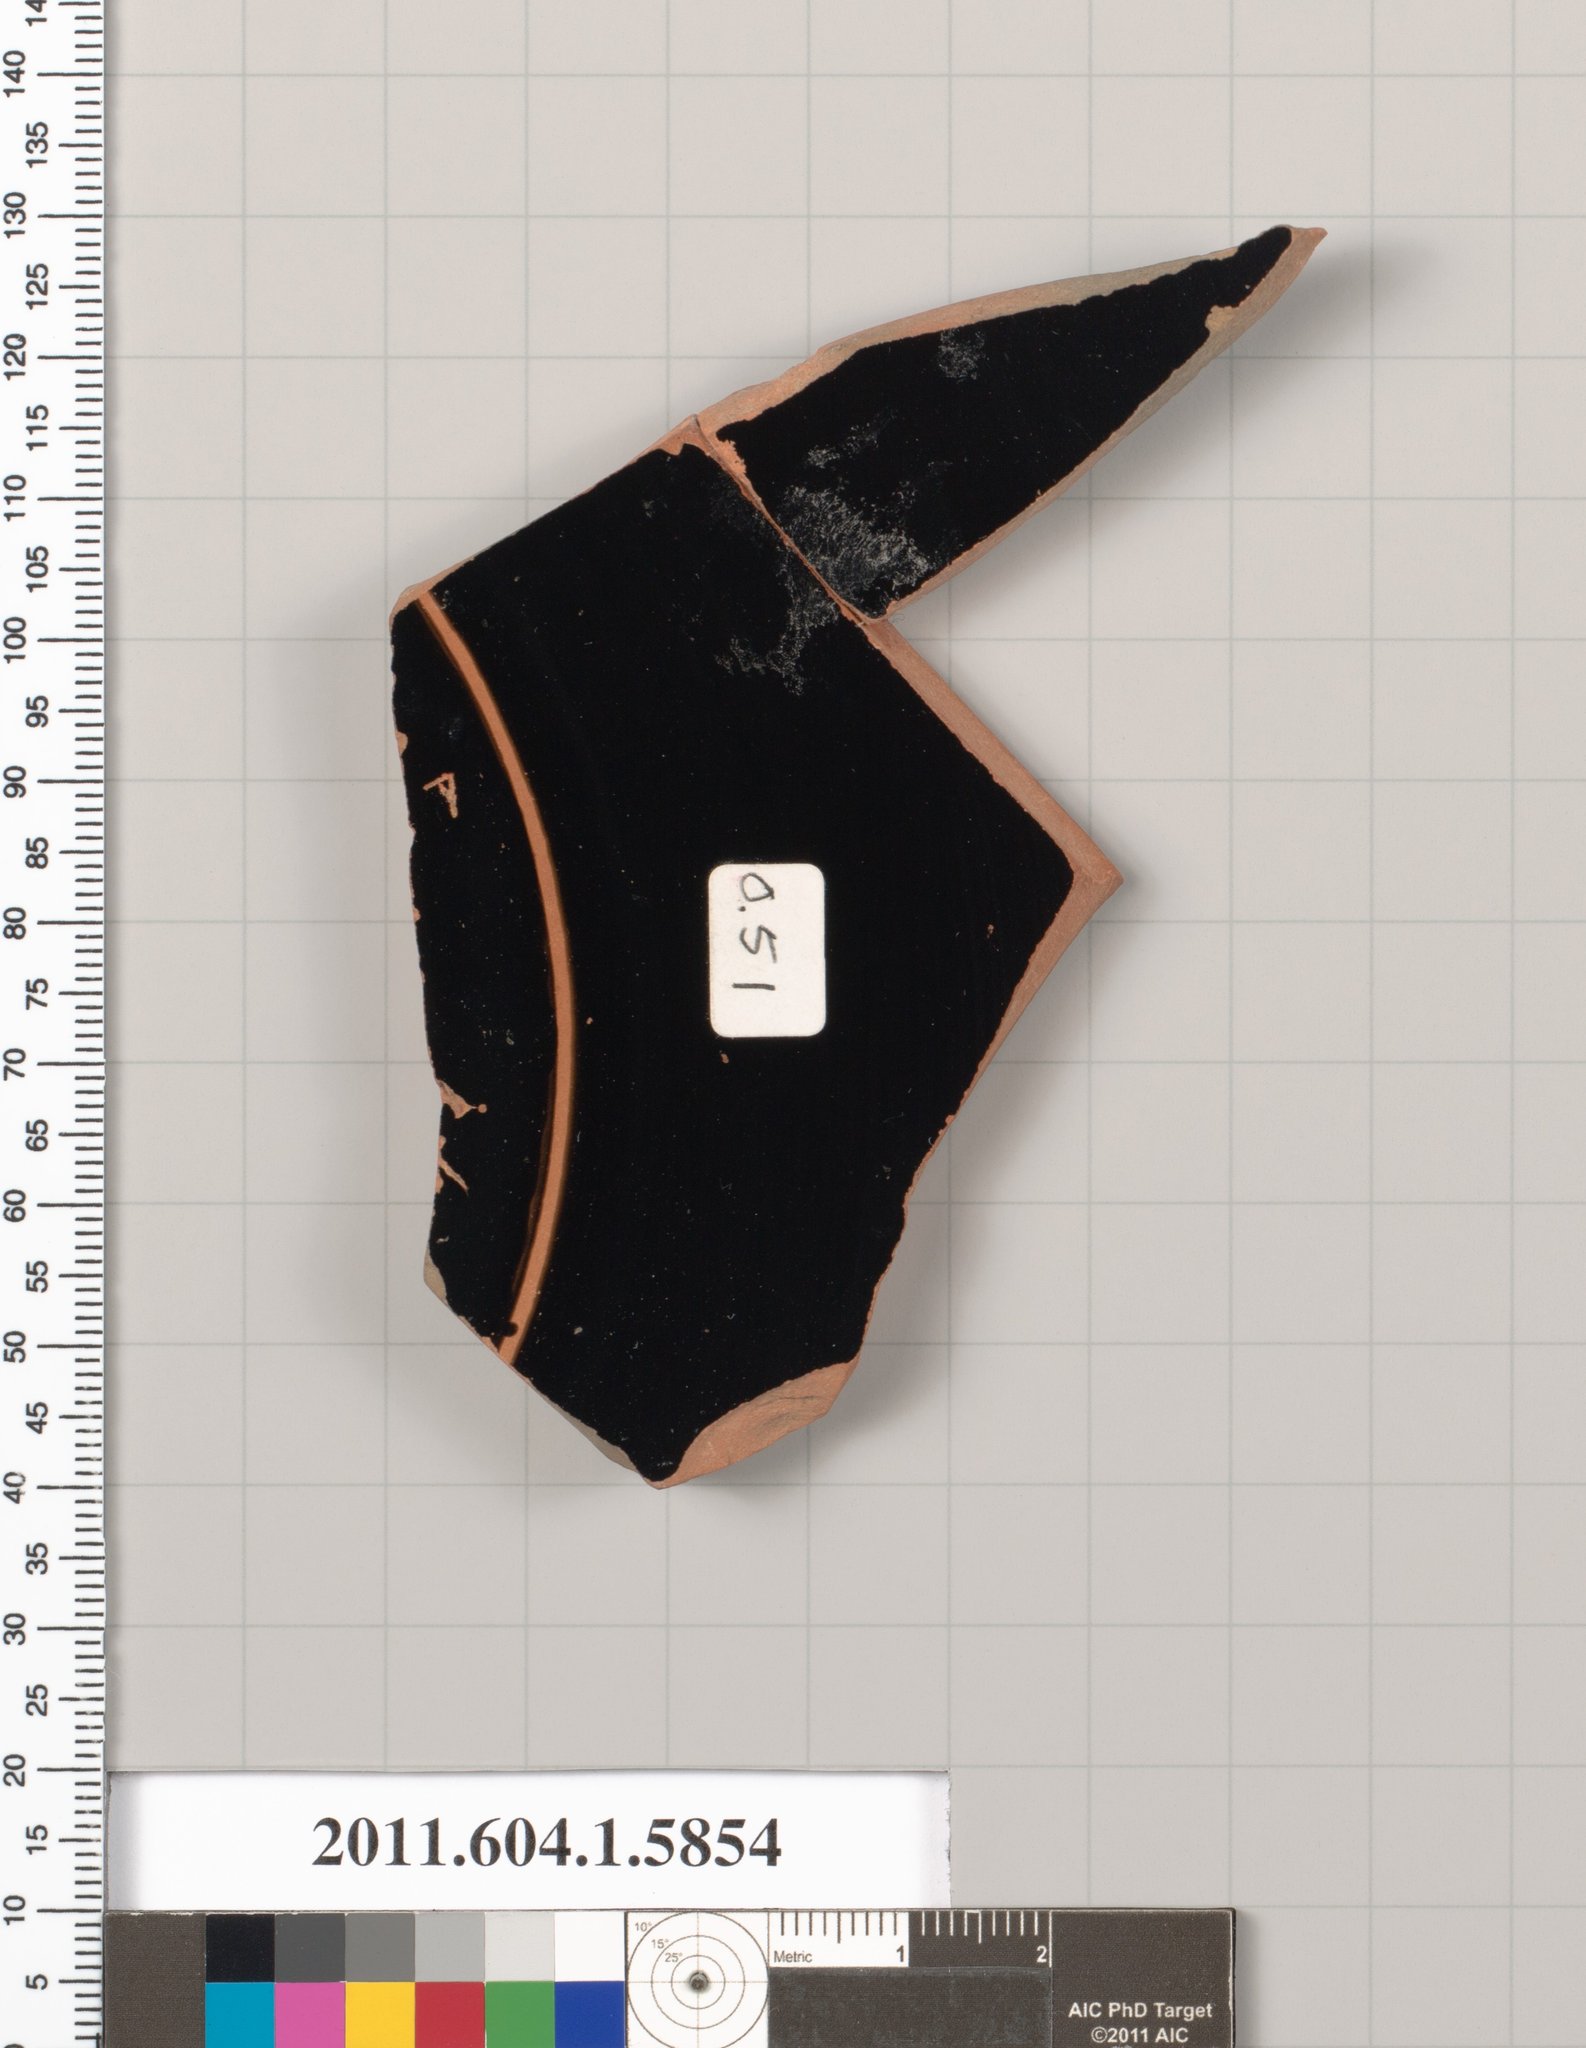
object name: kylix fragment, eye cup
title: Terracotta fragment of a kylix: eye-cup (drinking cup)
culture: greek, attic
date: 520-510 BCE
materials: terracotta